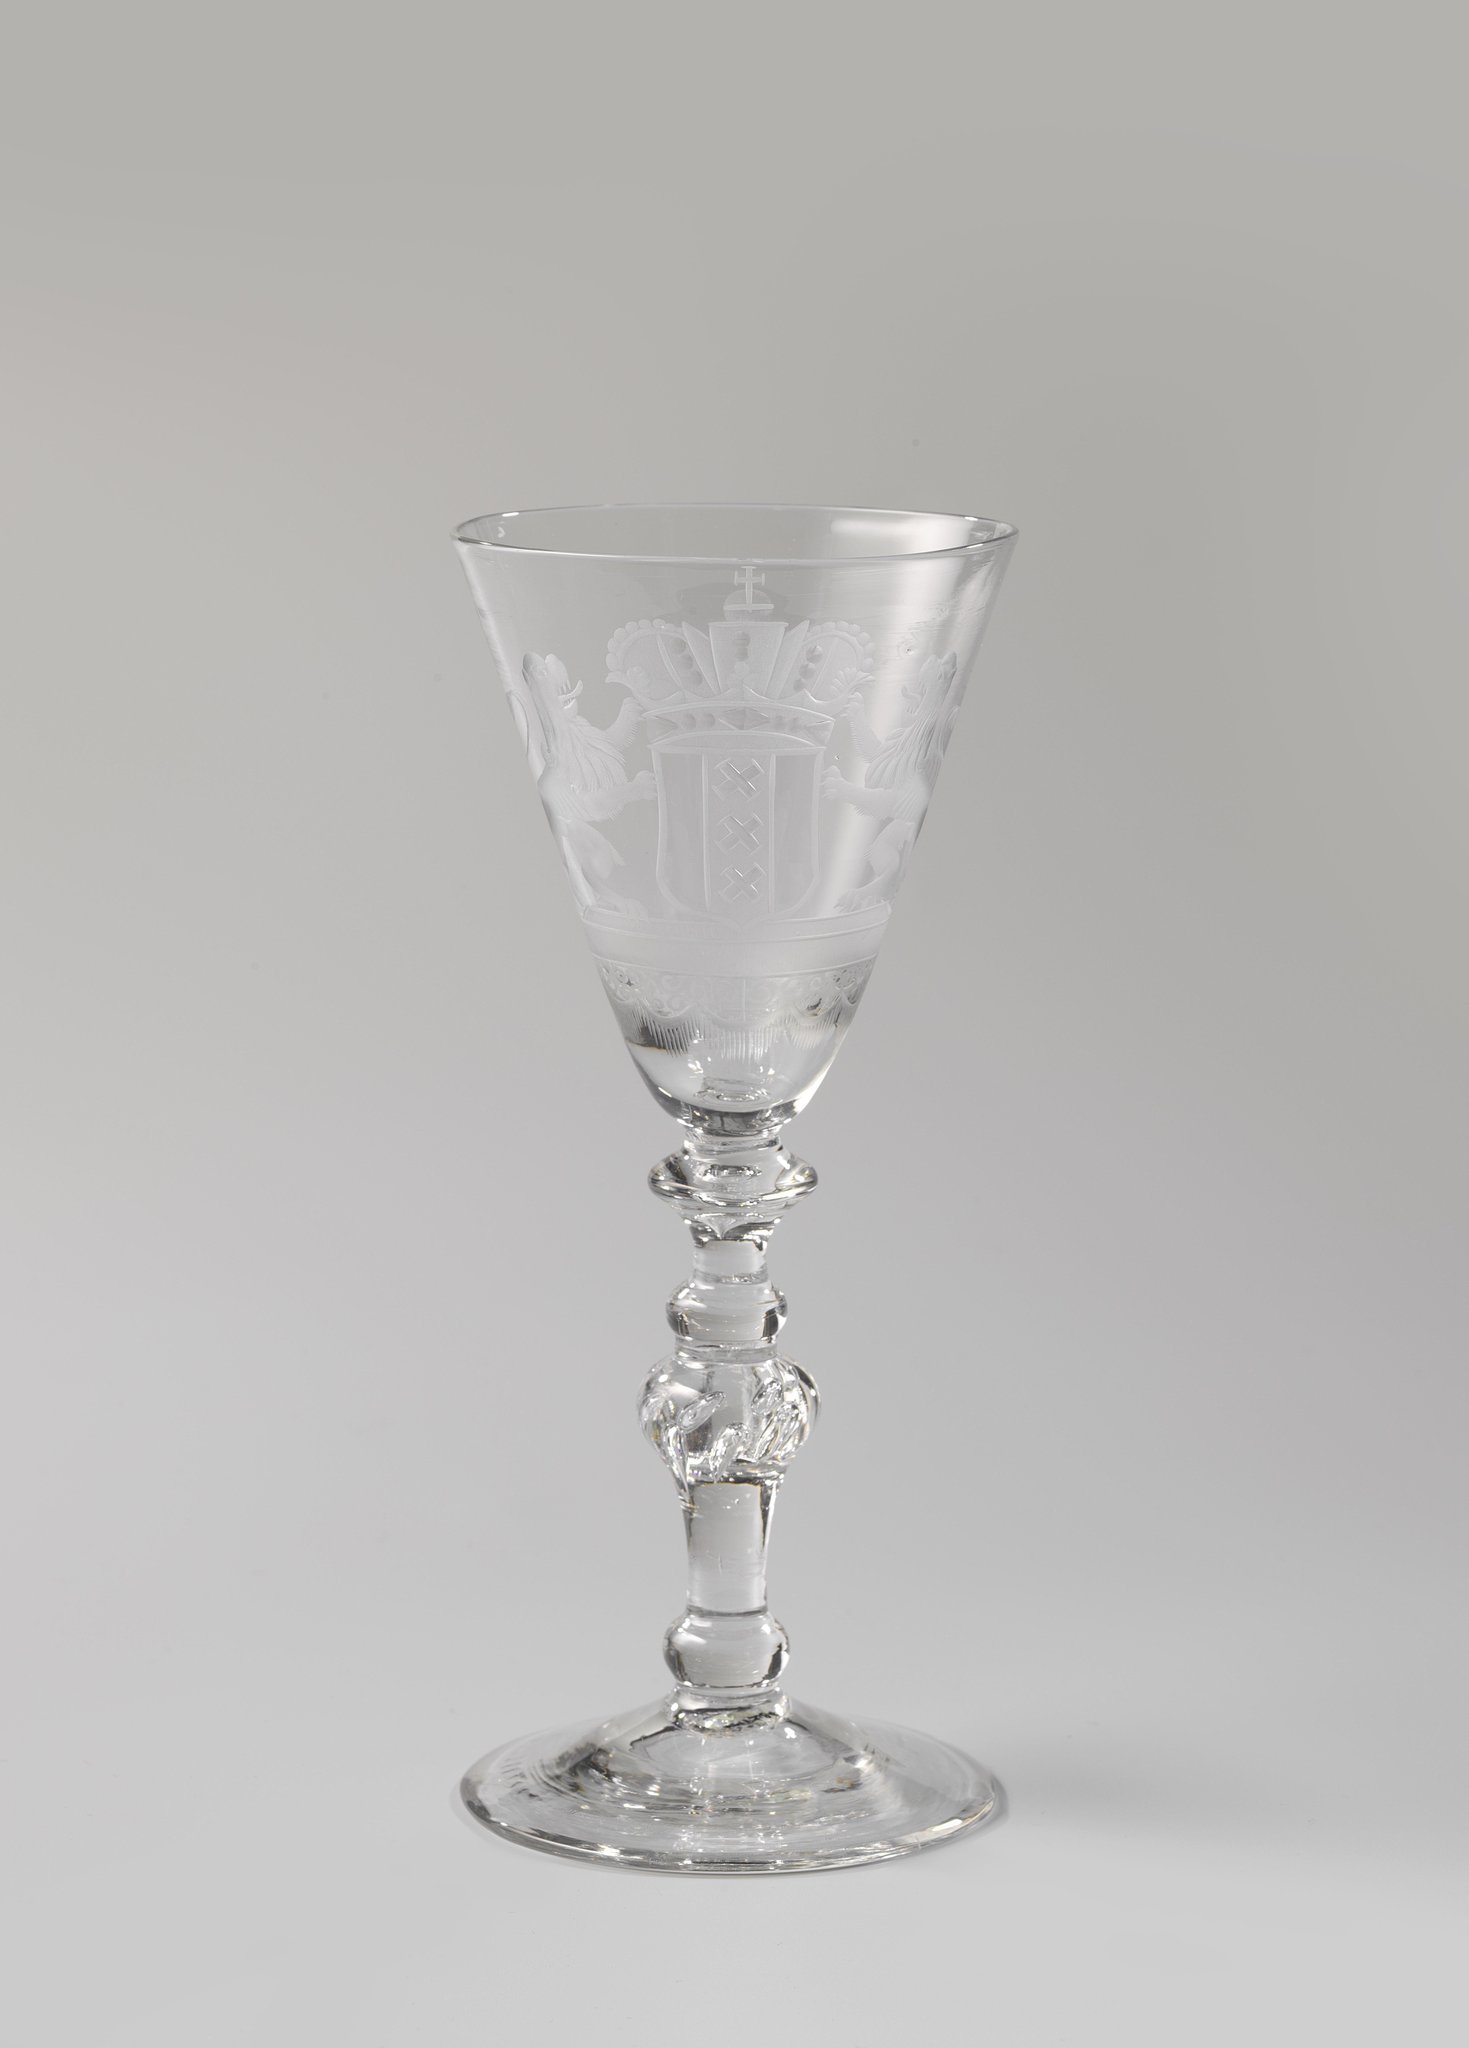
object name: goblet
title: Bokaal met het wapen van Amsterdam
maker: Anonymous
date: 1750-1775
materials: glass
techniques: glassblowing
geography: northern netherlands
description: Bokaal met conische voet. Balusterstam met vier knopen, in de bovenste één luchtbel en in de derde twee rijen luchtbellen. Op de conische kelk het wapen van Amsterdam.